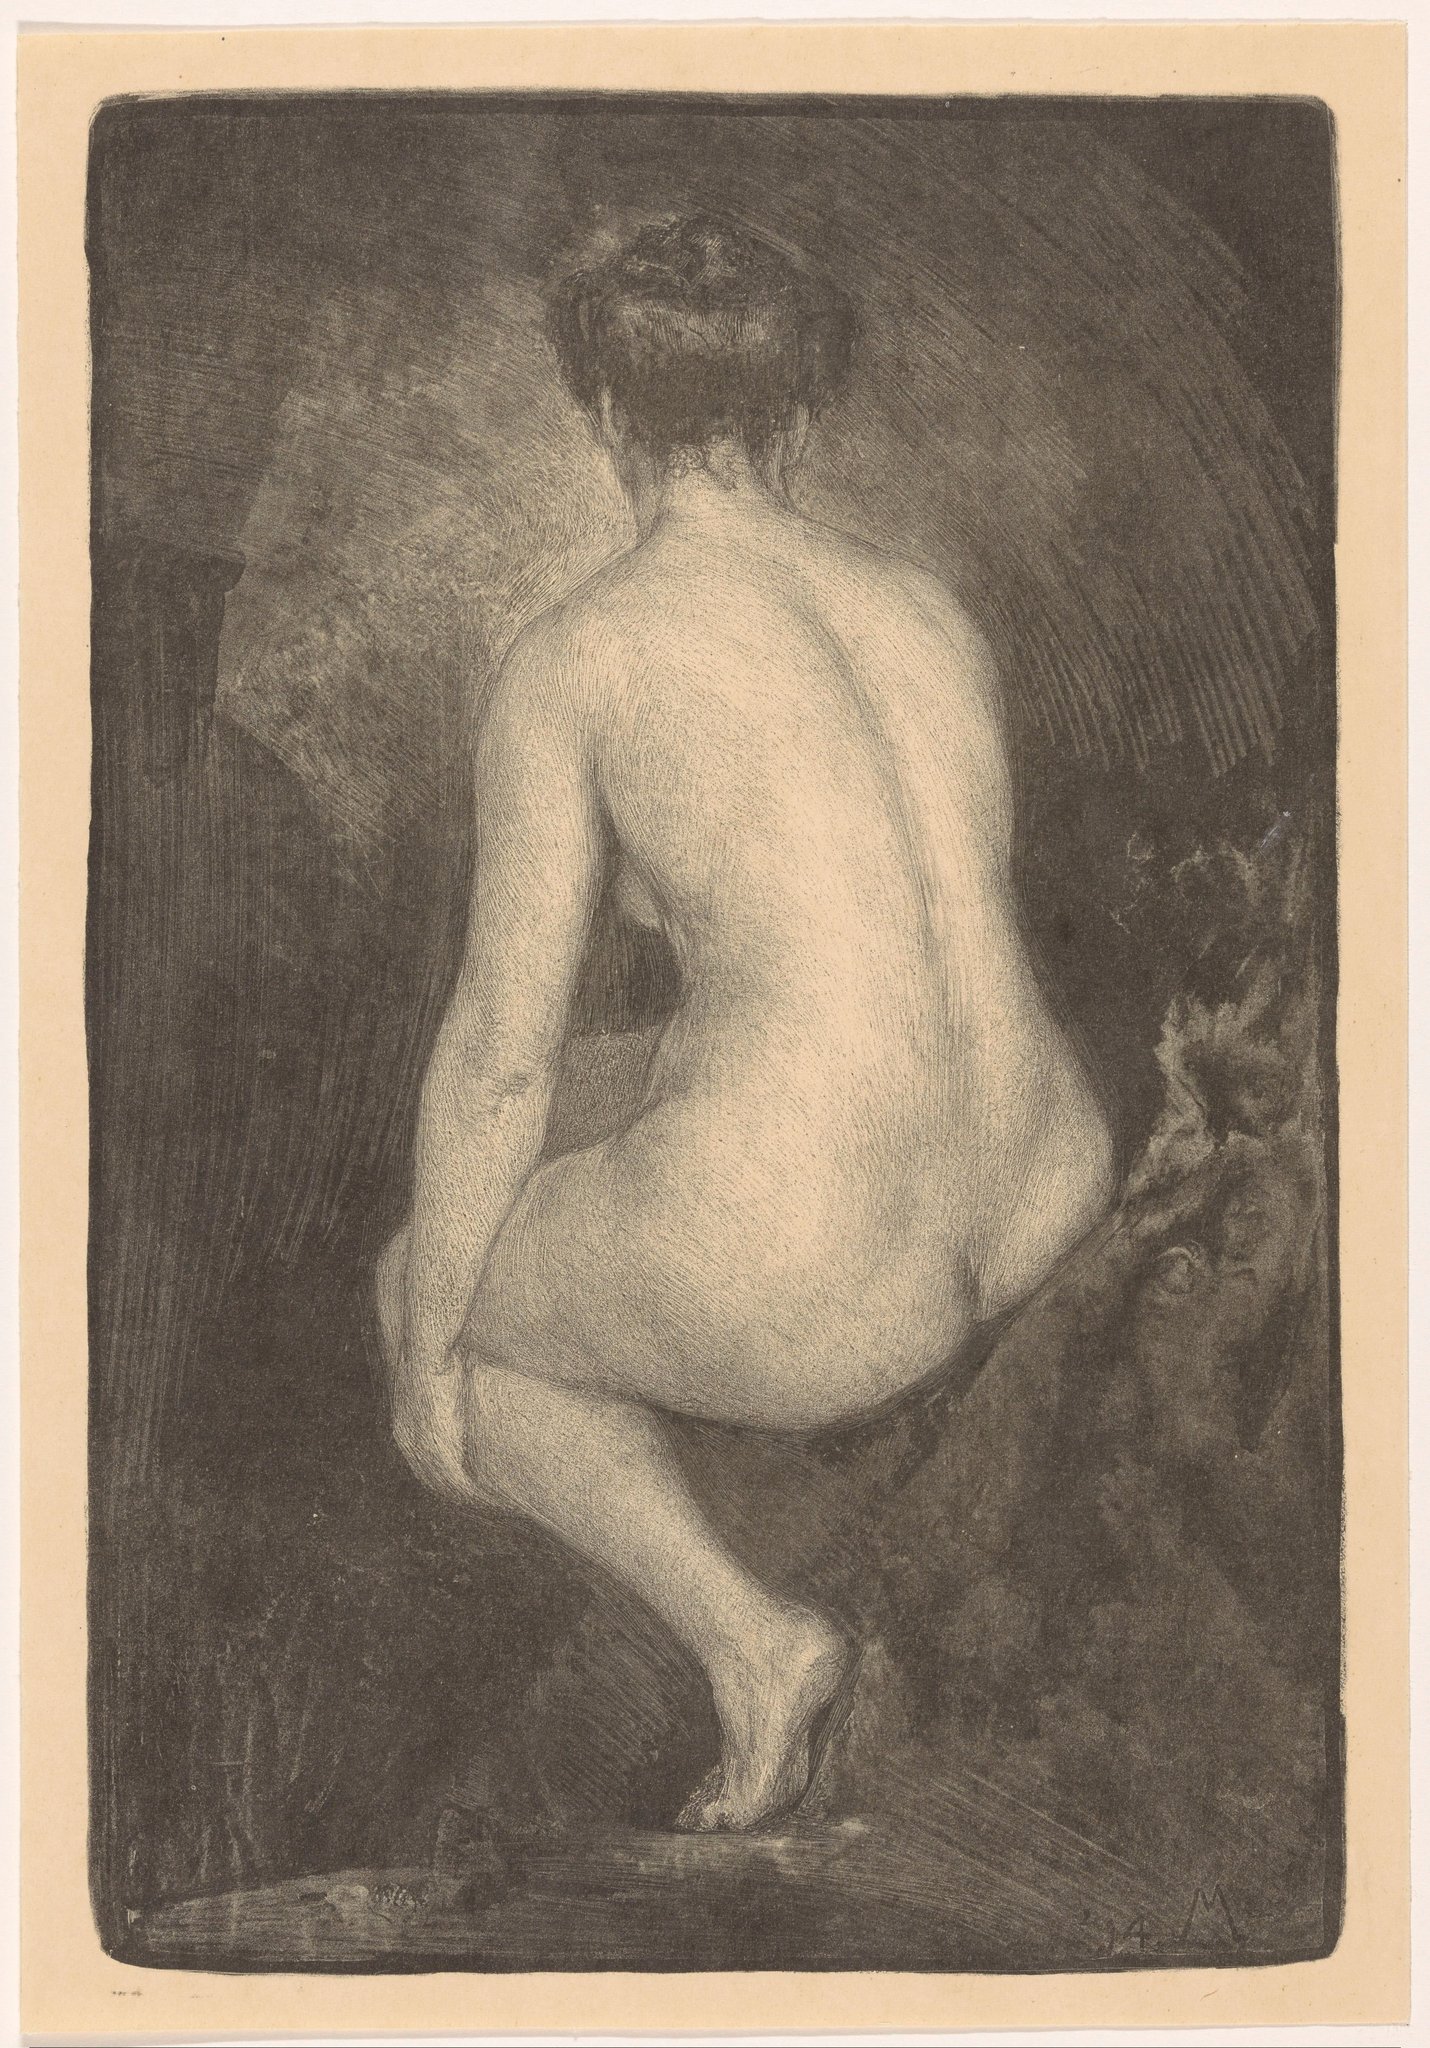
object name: print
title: Zittende naakte vrouw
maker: simon moulijn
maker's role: draughtsman, print maker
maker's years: 1866-1948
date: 1914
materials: paper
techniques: lithograph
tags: sitting figure - aa - female human figure, woman (showing herself) undressed, quasi-nude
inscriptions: collector's mark: Lugt 2228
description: Een naakte zittende vrouw, op de rug gezien voor een donkere achtergrond.